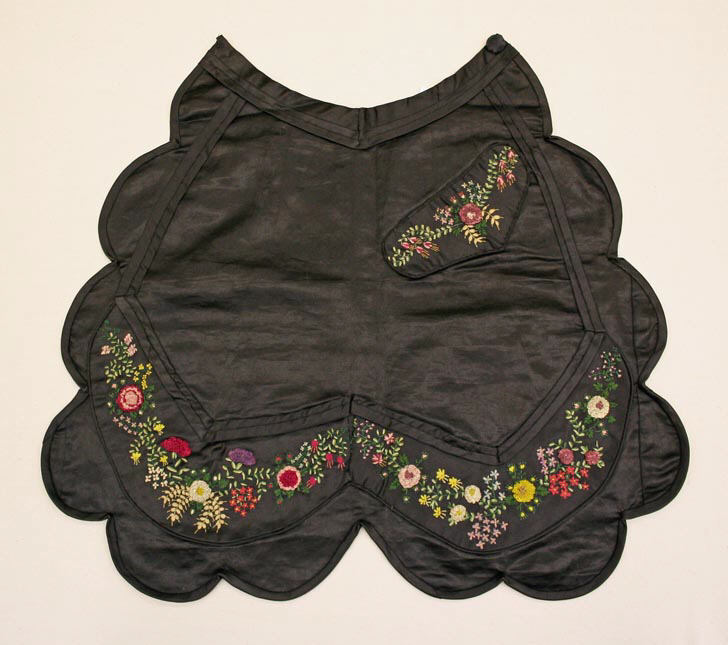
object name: apron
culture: british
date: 1868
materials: silk